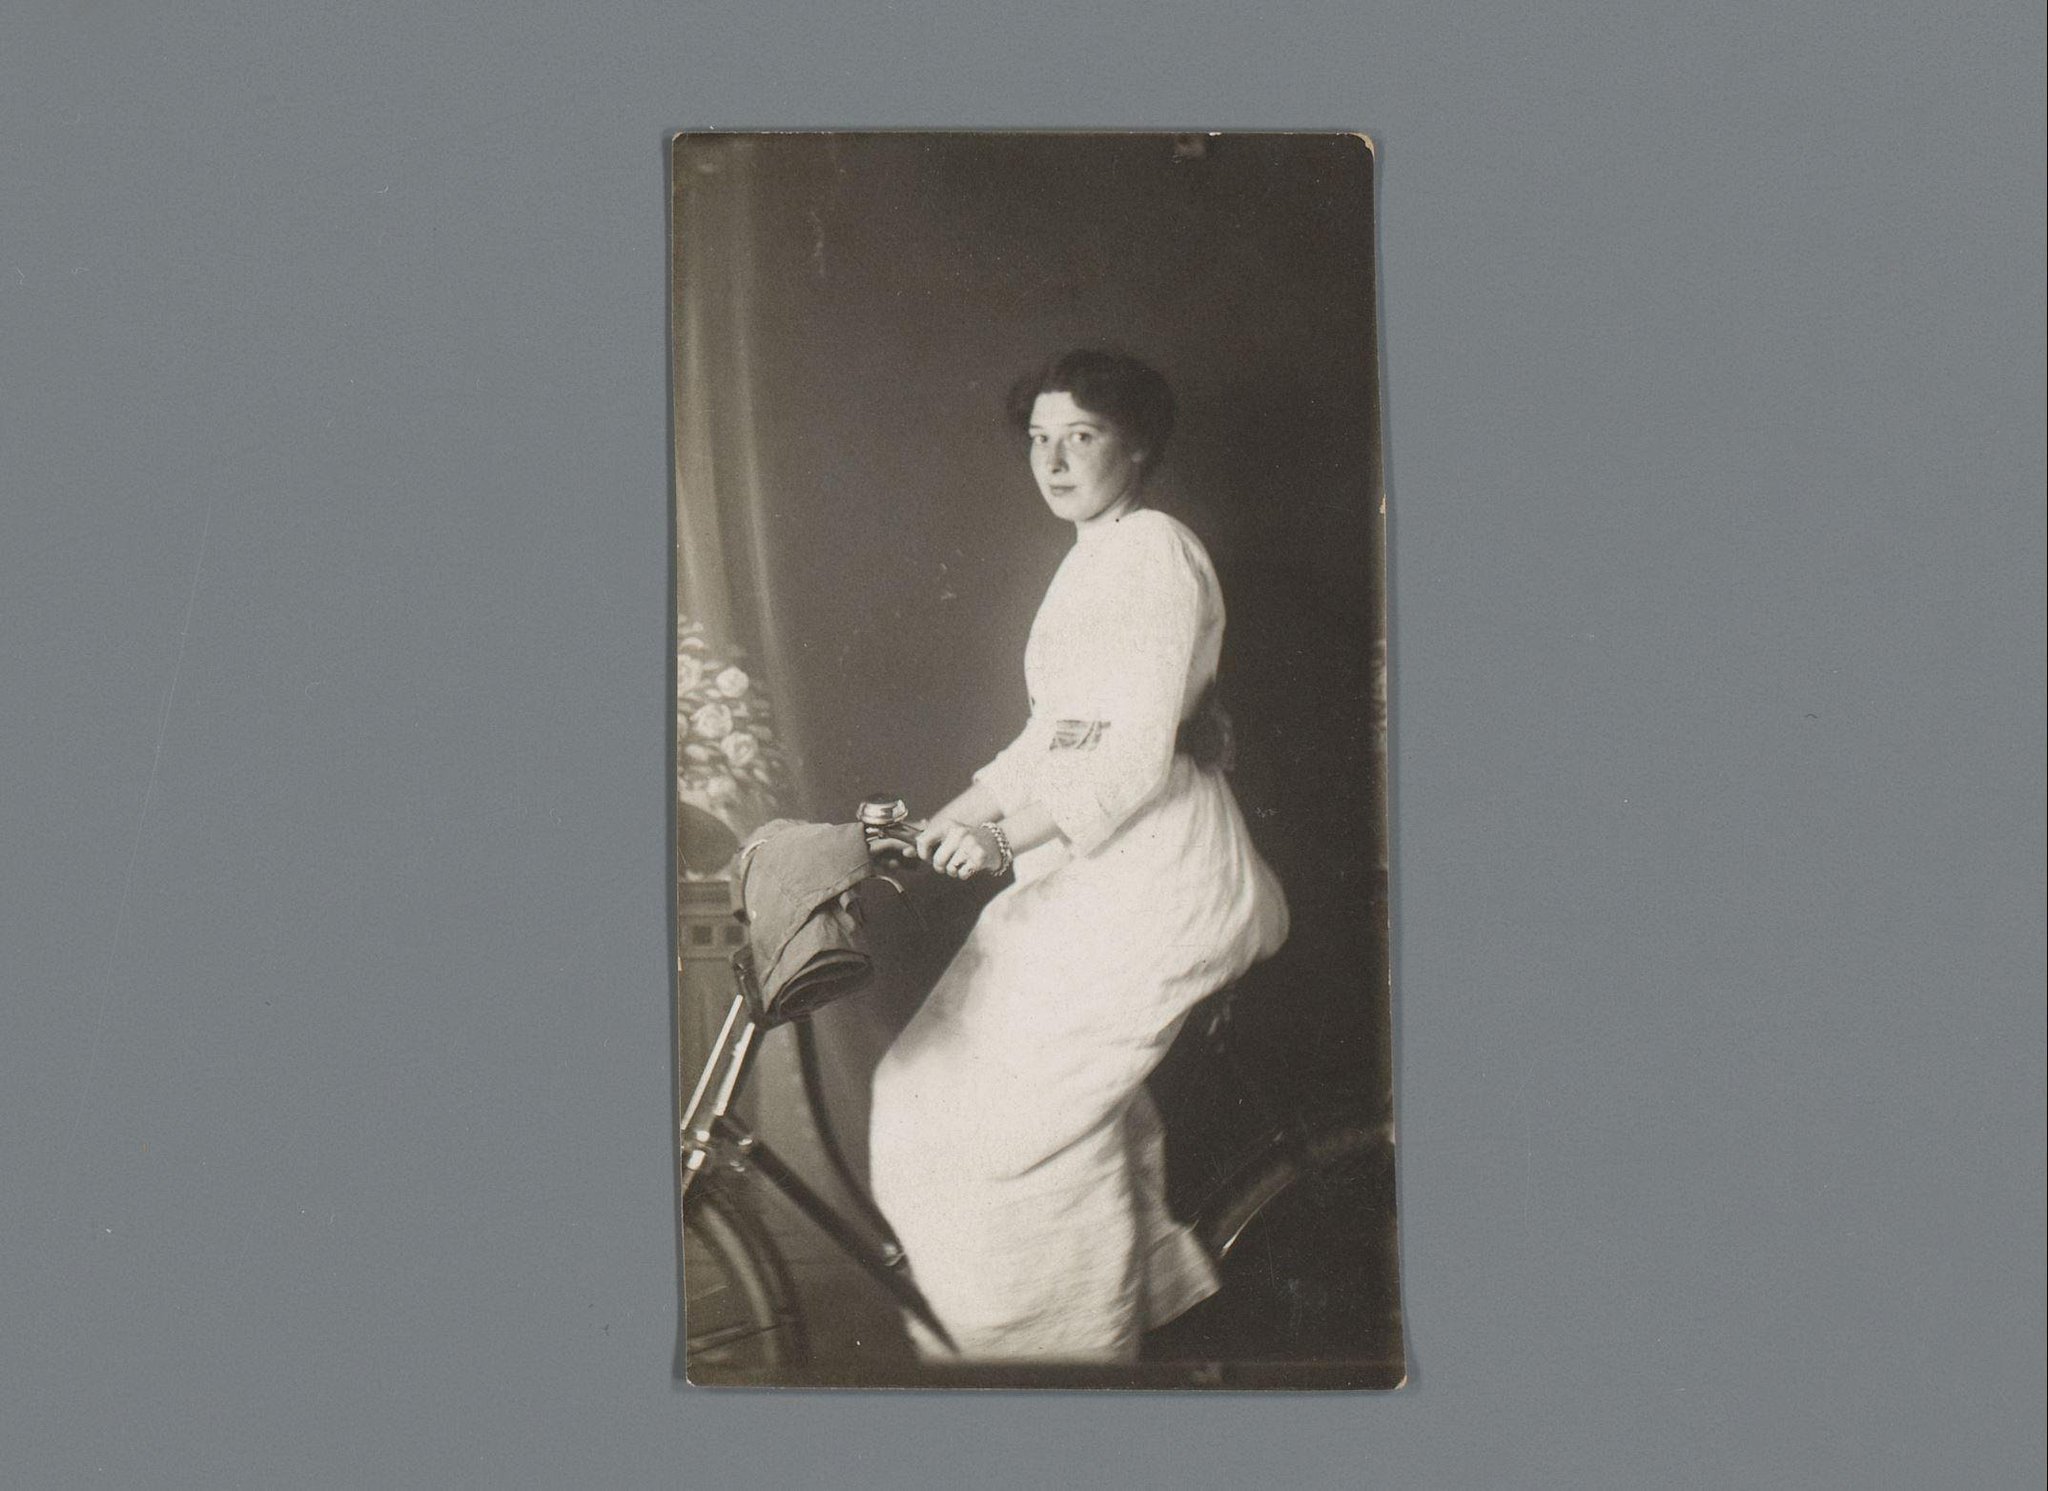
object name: snapshot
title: Rapid photographs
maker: Anonymous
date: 1914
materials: paper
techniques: gelatin silver print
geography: apeldoorn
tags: adolescent, young woman, maiden, anonymous historical person portrayed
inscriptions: inscription: ‘Apeldoorn 17 Juli 1914’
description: Between 1912 and 1930, anyone could have their portrait taken at the many so-called rapid photography studios in the shopping streets of mainly (medium) large-size European cities. As if on an assembly line, the youngest clerk shot the photographs with a special camera and in artificial light and developed them. Later in the day, the customer collected a sheet with 12 portrait photos for 25 cents. This form of photographic mass production gave rise to a fascinating tableau of boys, girls, men and women not previously seen in photographs; candid and informal. There were at least 150 quick-photo studios, from Alkmaar to Zutphen. Many called themselves ‘American,’ mistakenly as it turns out because hardly any examples from that country have been found.